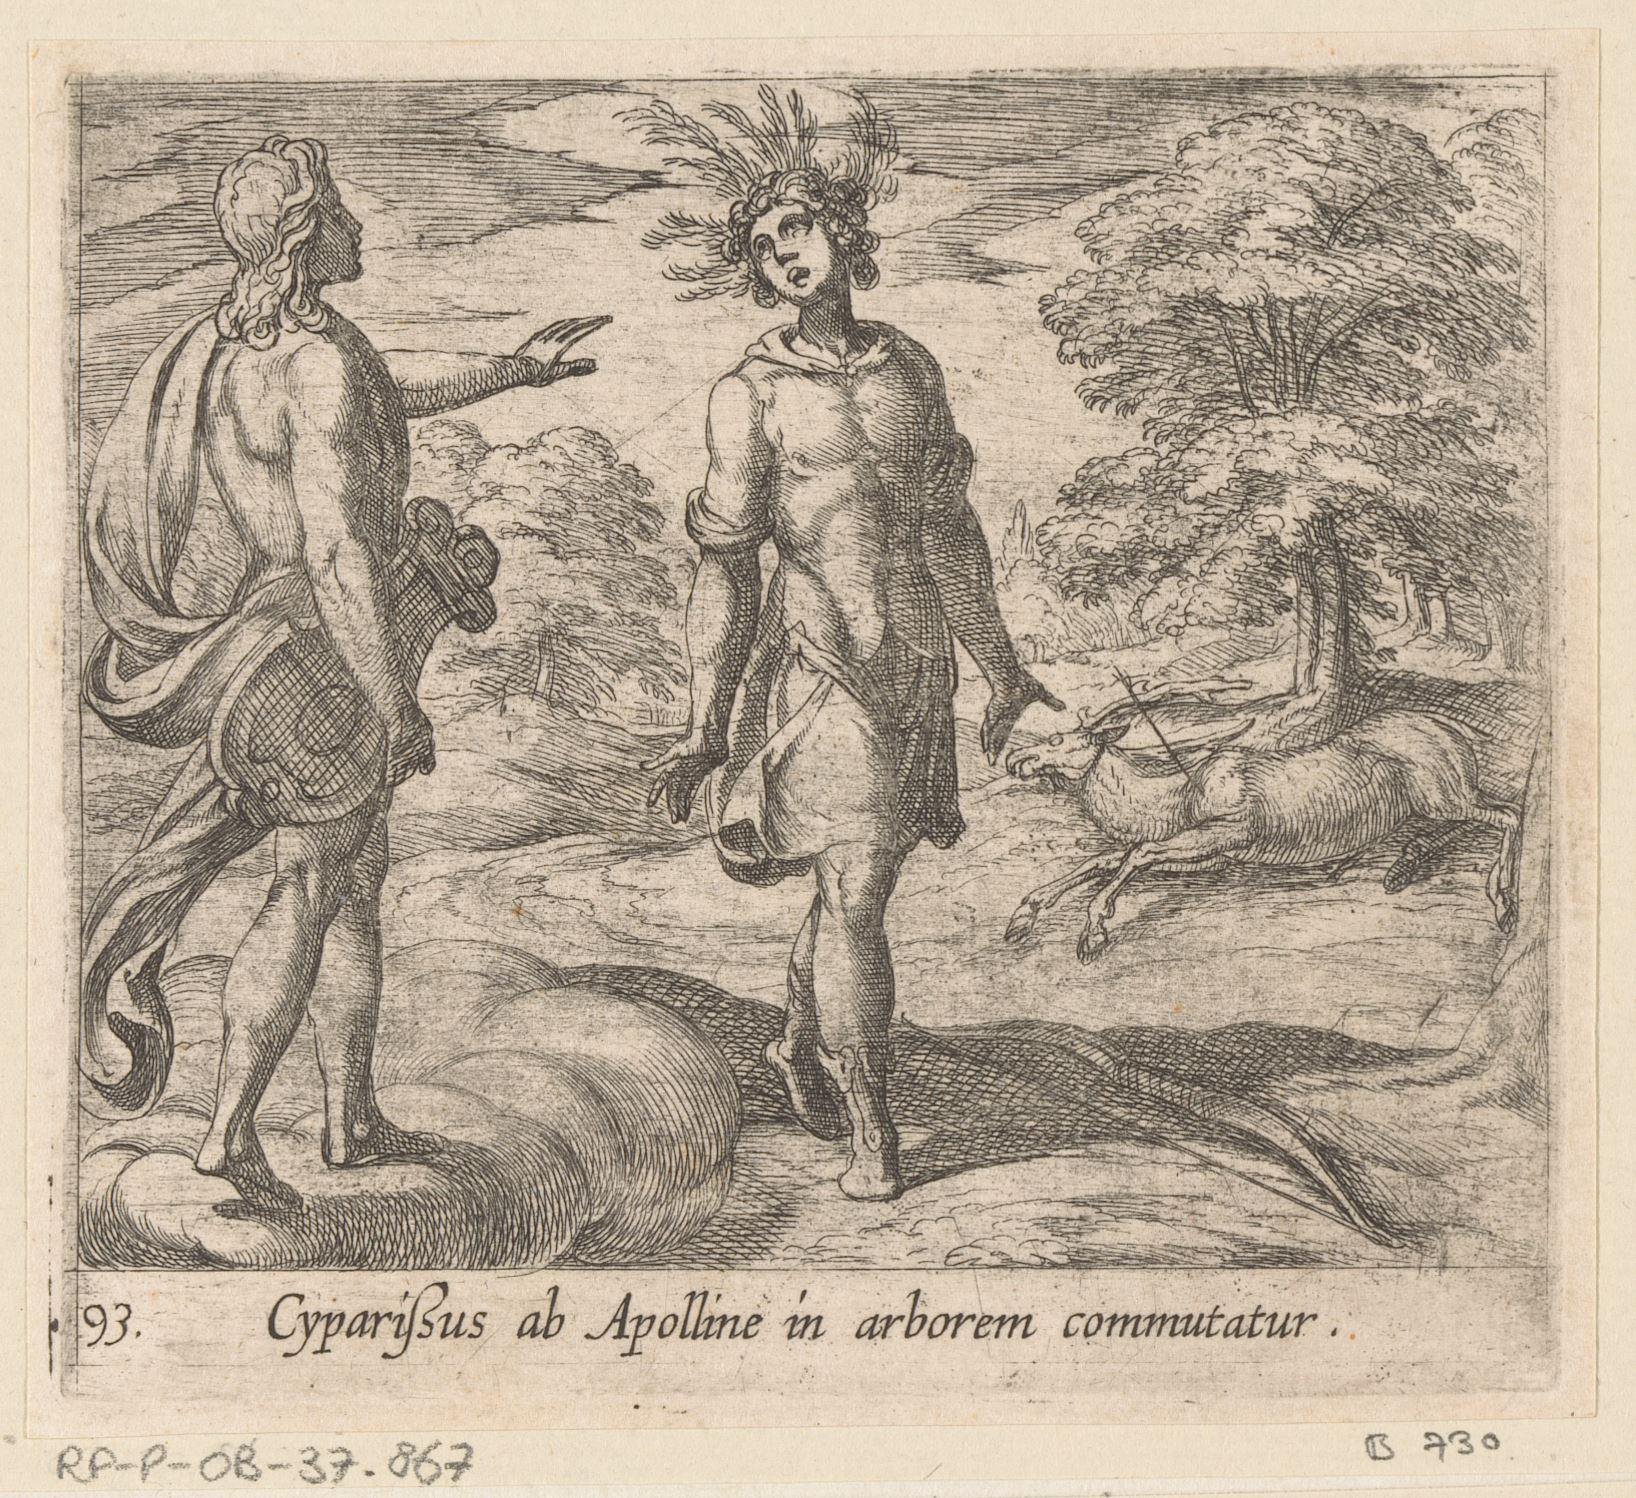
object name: print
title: Metamorfosen van Ovidius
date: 1606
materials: paper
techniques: etching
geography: antwerp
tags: homosexual love, cyparissus changed into a cypress: when pining away for the loss of his favourite stag, cyparissus the hunter, minion of apollo, is changed into a cypress by the god (ovid, metamorphoses x 106)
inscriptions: collector's mark: Lugt 240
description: Deze prent maakt deel uit van een reeks van 150 prenten (+ titelprent) met voorstellingen van de Metamorfosen van Ovidius.